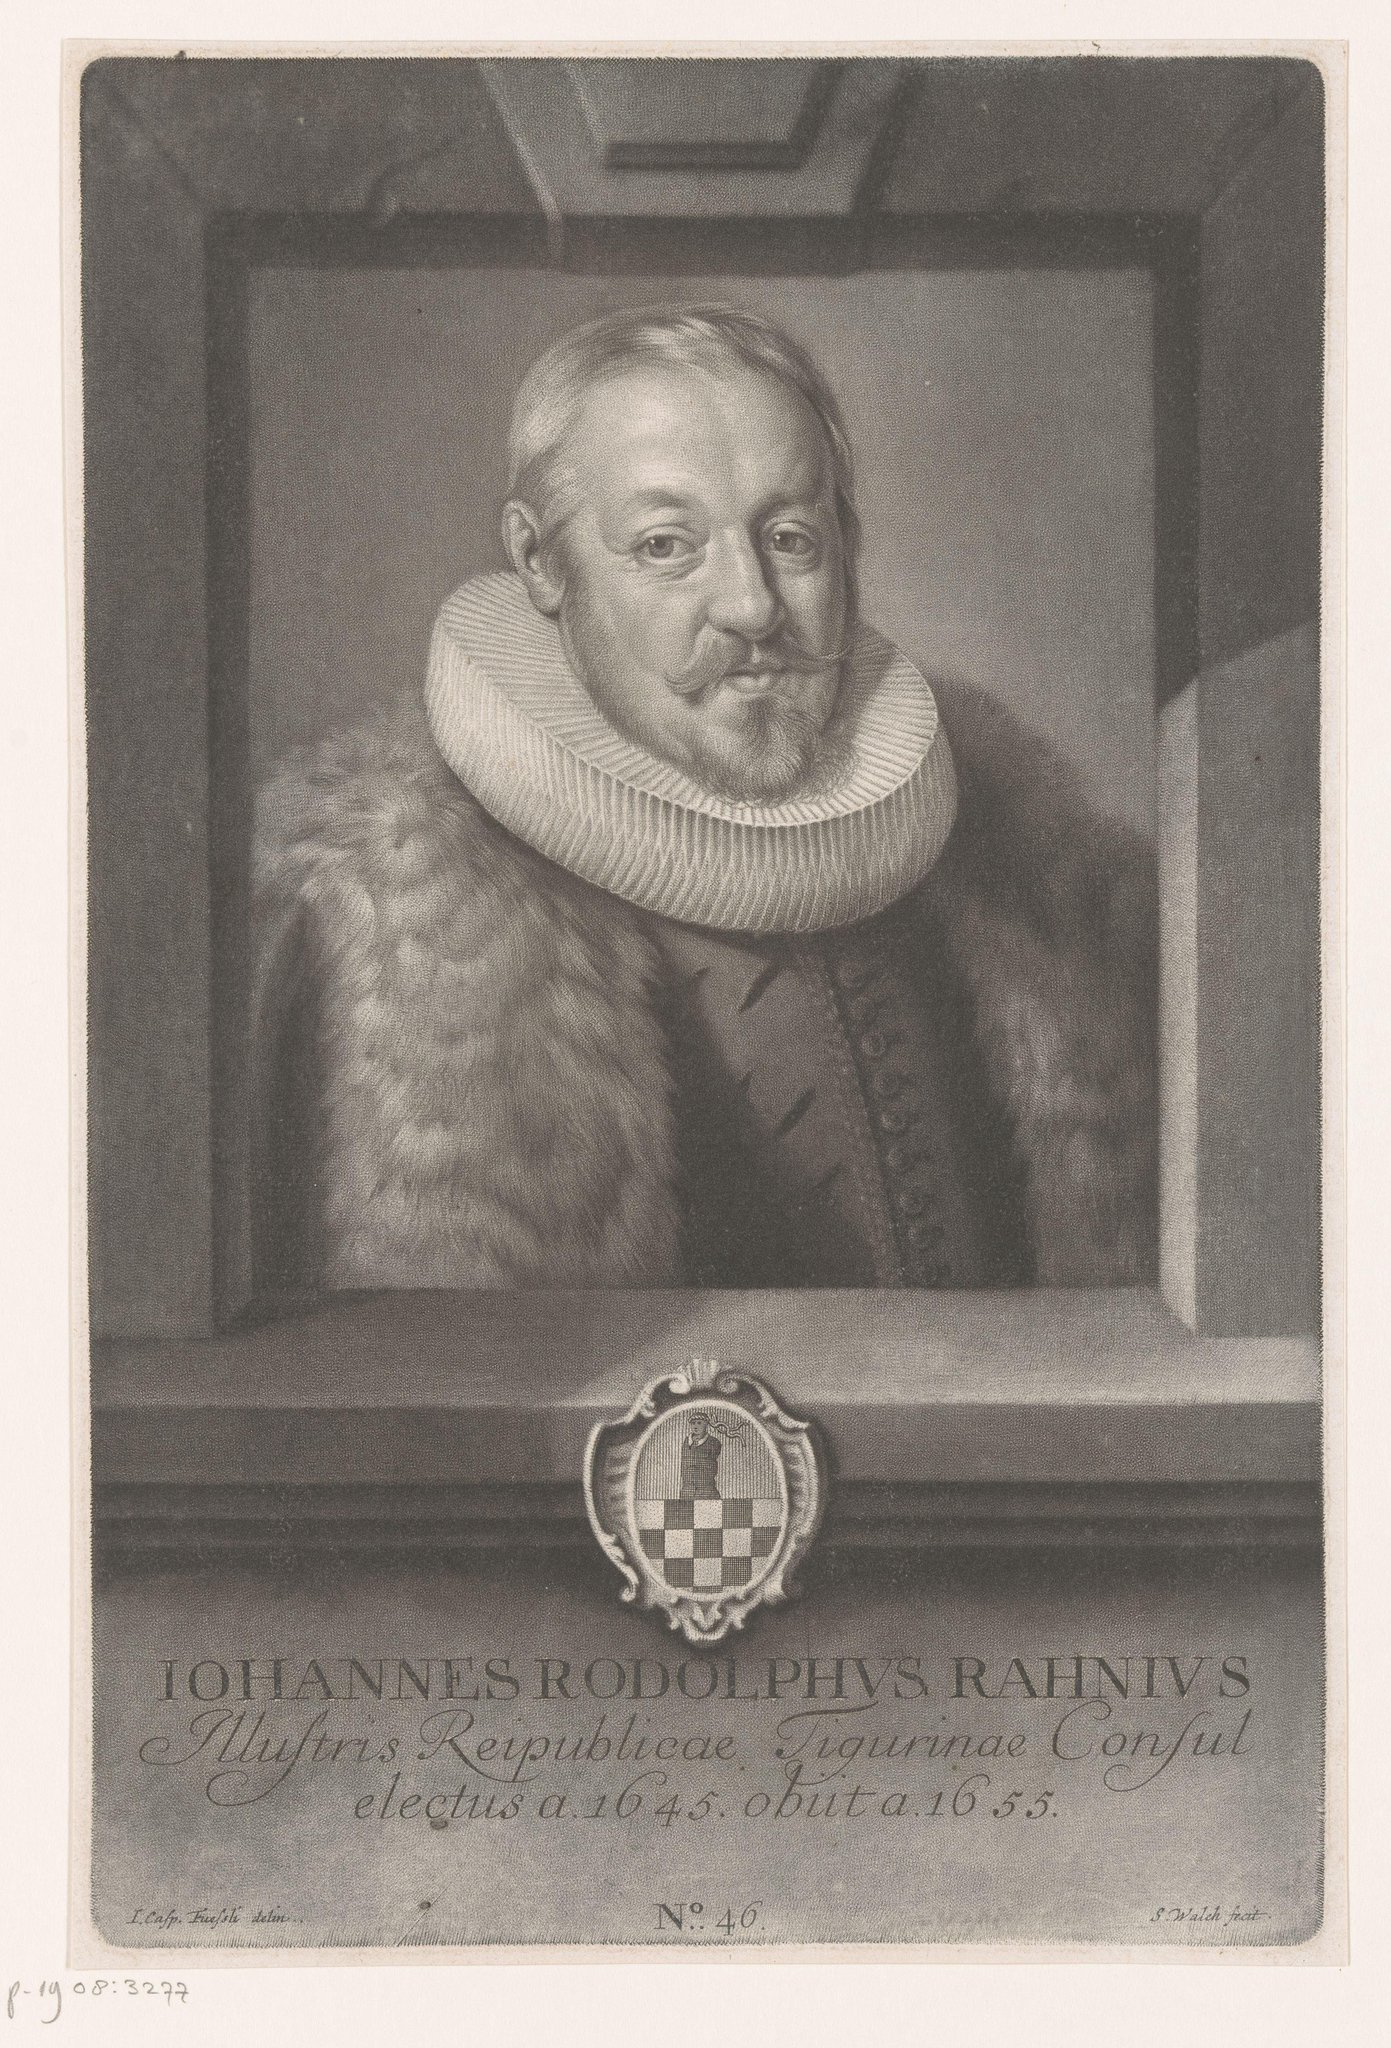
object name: print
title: Portret van Johann Rudolf Rahn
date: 1731-1788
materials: paper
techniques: mezzotint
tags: mayor, historical persons, armorial bearing, heraldry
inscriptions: collector's mark: Lugt 2228